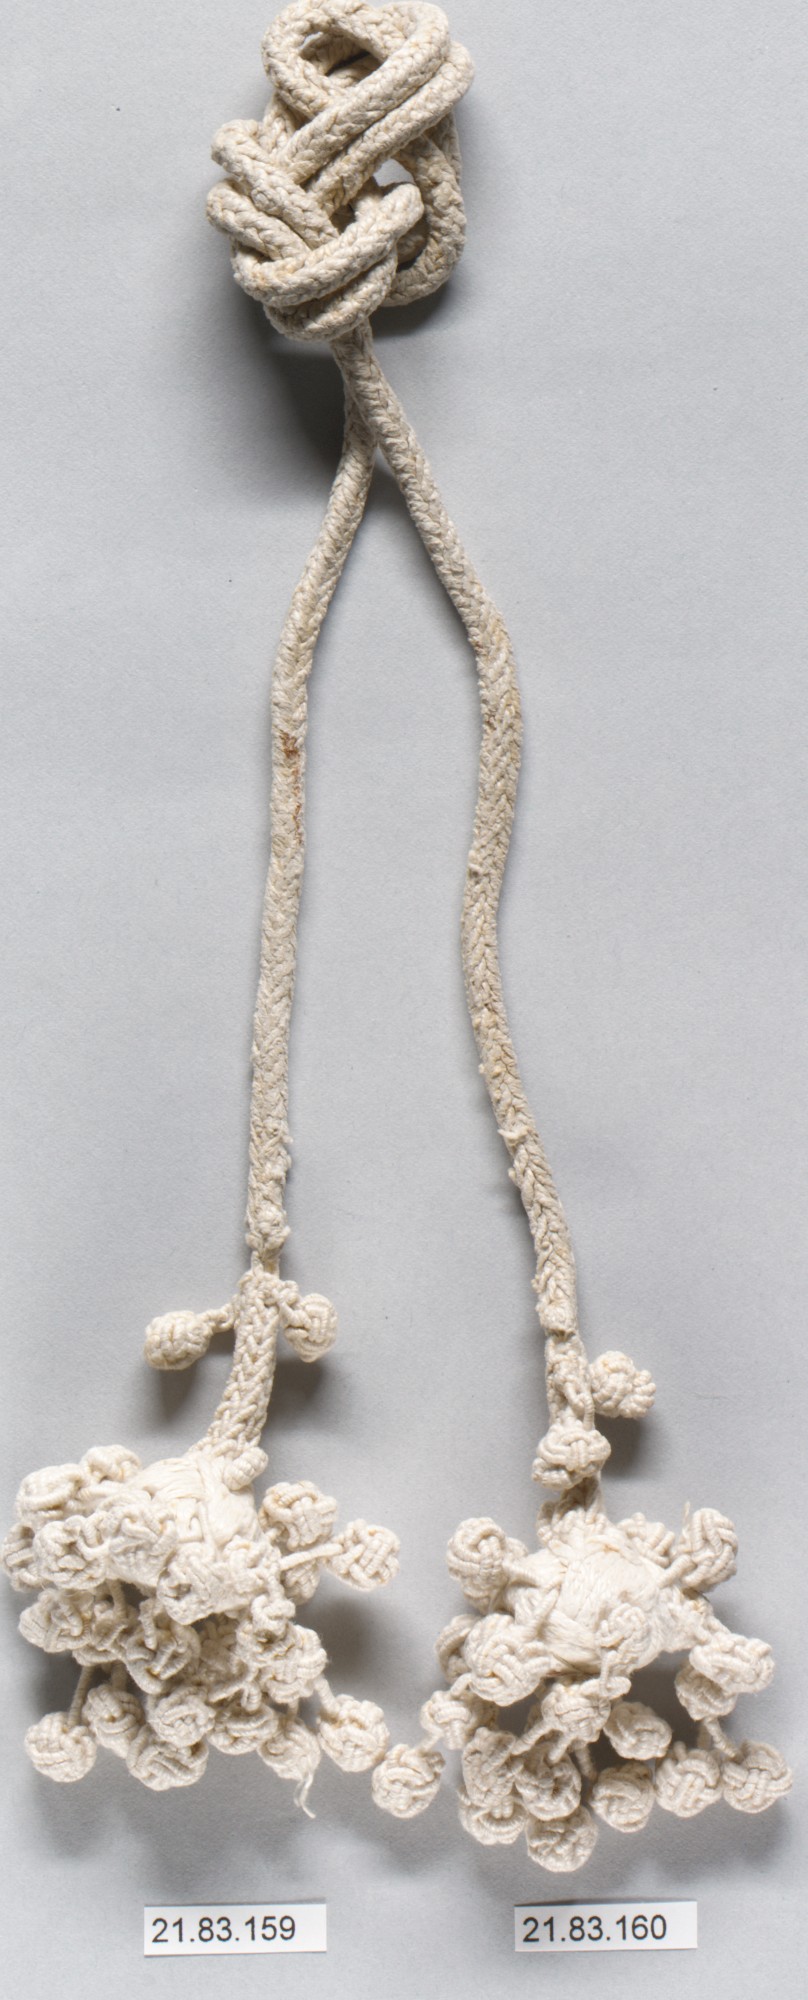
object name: tassel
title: Pair of tassels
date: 1601-1700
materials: linen